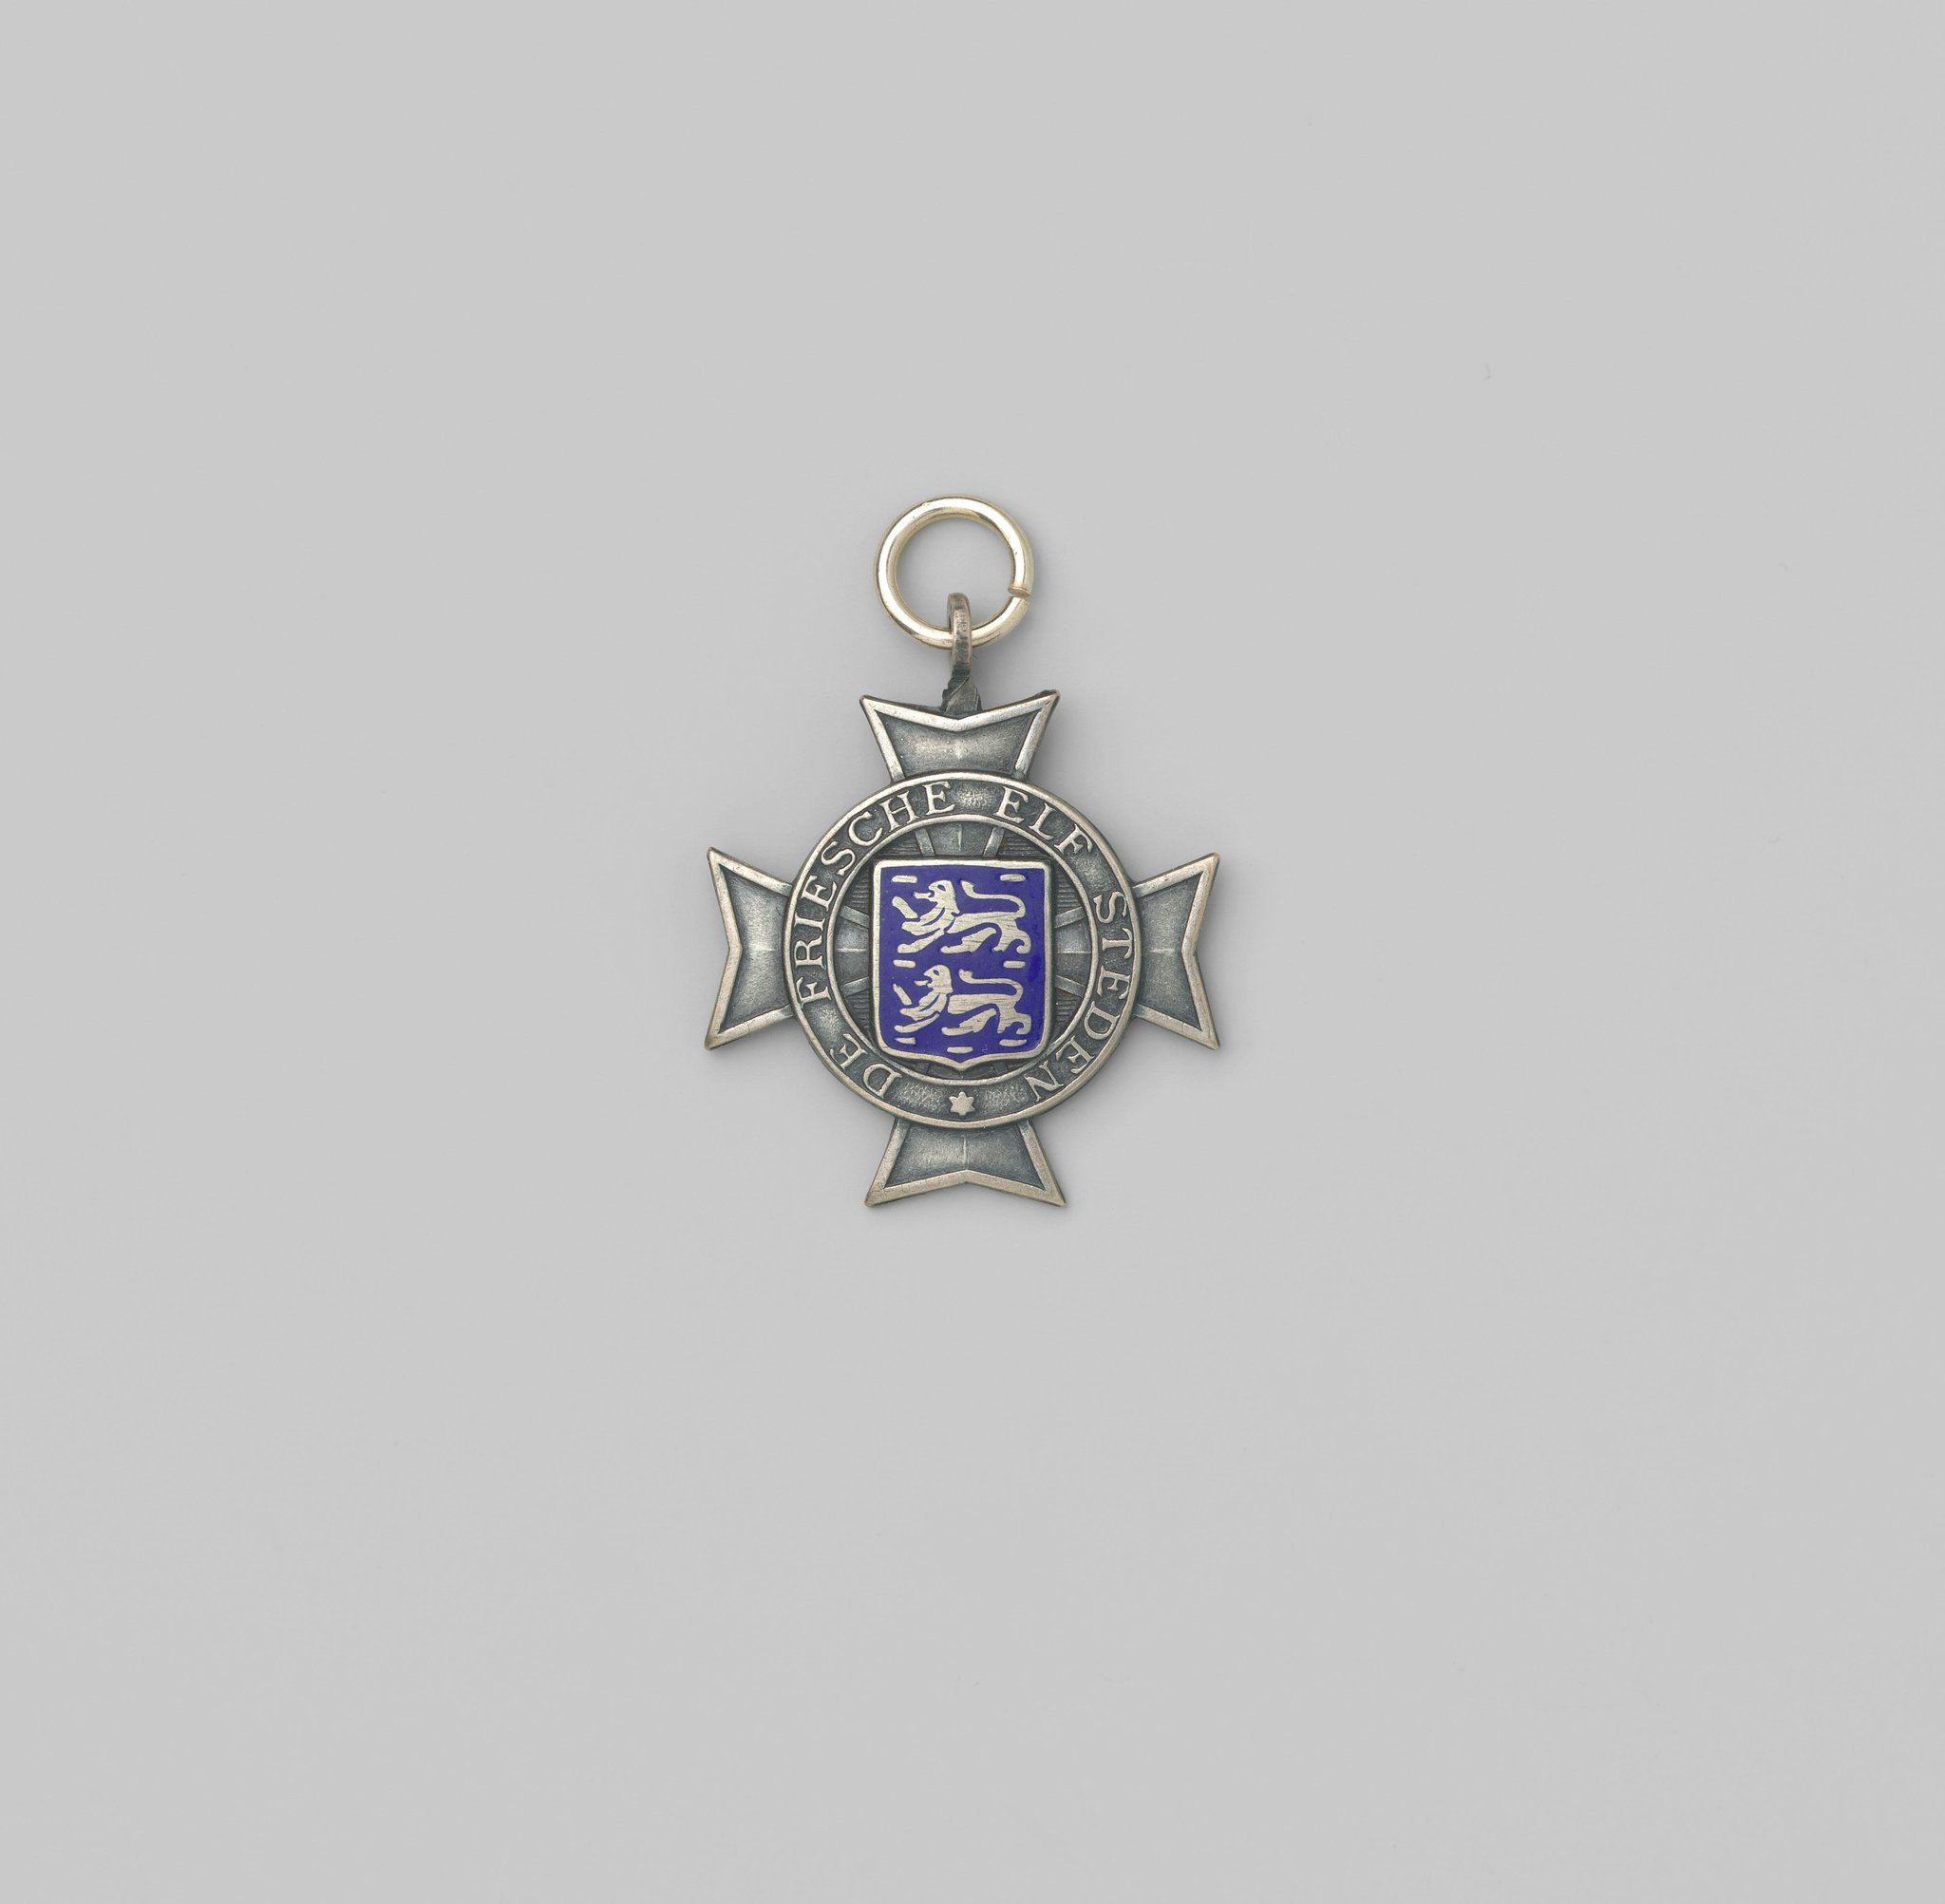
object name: onderscheidingsteken, onderscheiding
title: Het Elfstedenkruisje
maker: pim mulier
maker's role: designer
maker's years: 1865-1954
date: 1909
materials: metal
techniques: striking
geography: voorschoten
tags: eleven cities tour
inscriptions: inscription: ‘26 FEBR. 1986’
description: Maltezerkruis waarbinnen band met tekst 'De Friesche Elf Steden', waarbinnen blauw geemailleerd wapen (van Friesland) met boven elkaar twee naar links lopende leeuwen, met draagoog waaraan ringetje; keerzijde: in cirkel datum '26 FEBR. 1986'.